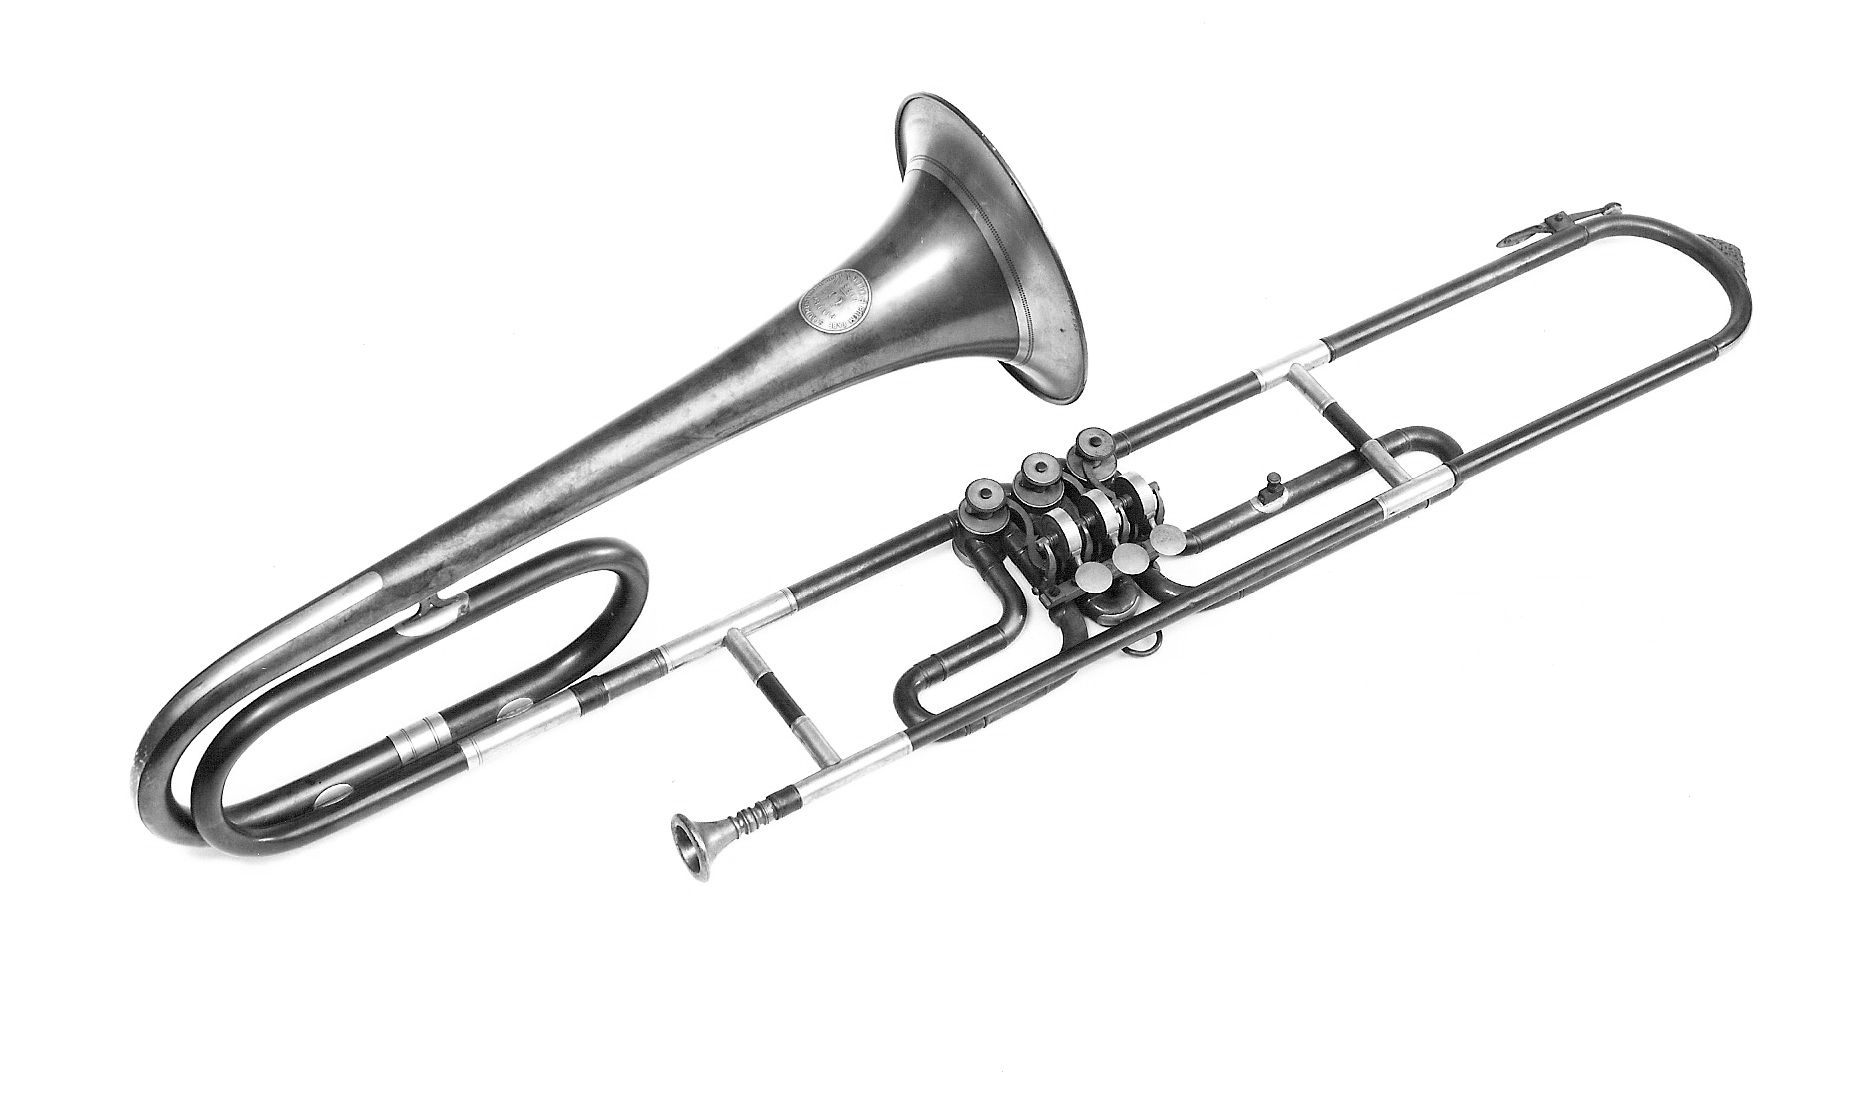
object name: tenor valve trombone in b flat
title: Tenor Valve Trombone in B-flat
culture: italian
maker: pietro borsari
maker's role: maker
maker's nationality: italian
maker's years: 1850-1900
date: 1867-1900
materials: brass, nickel, silver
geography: italy